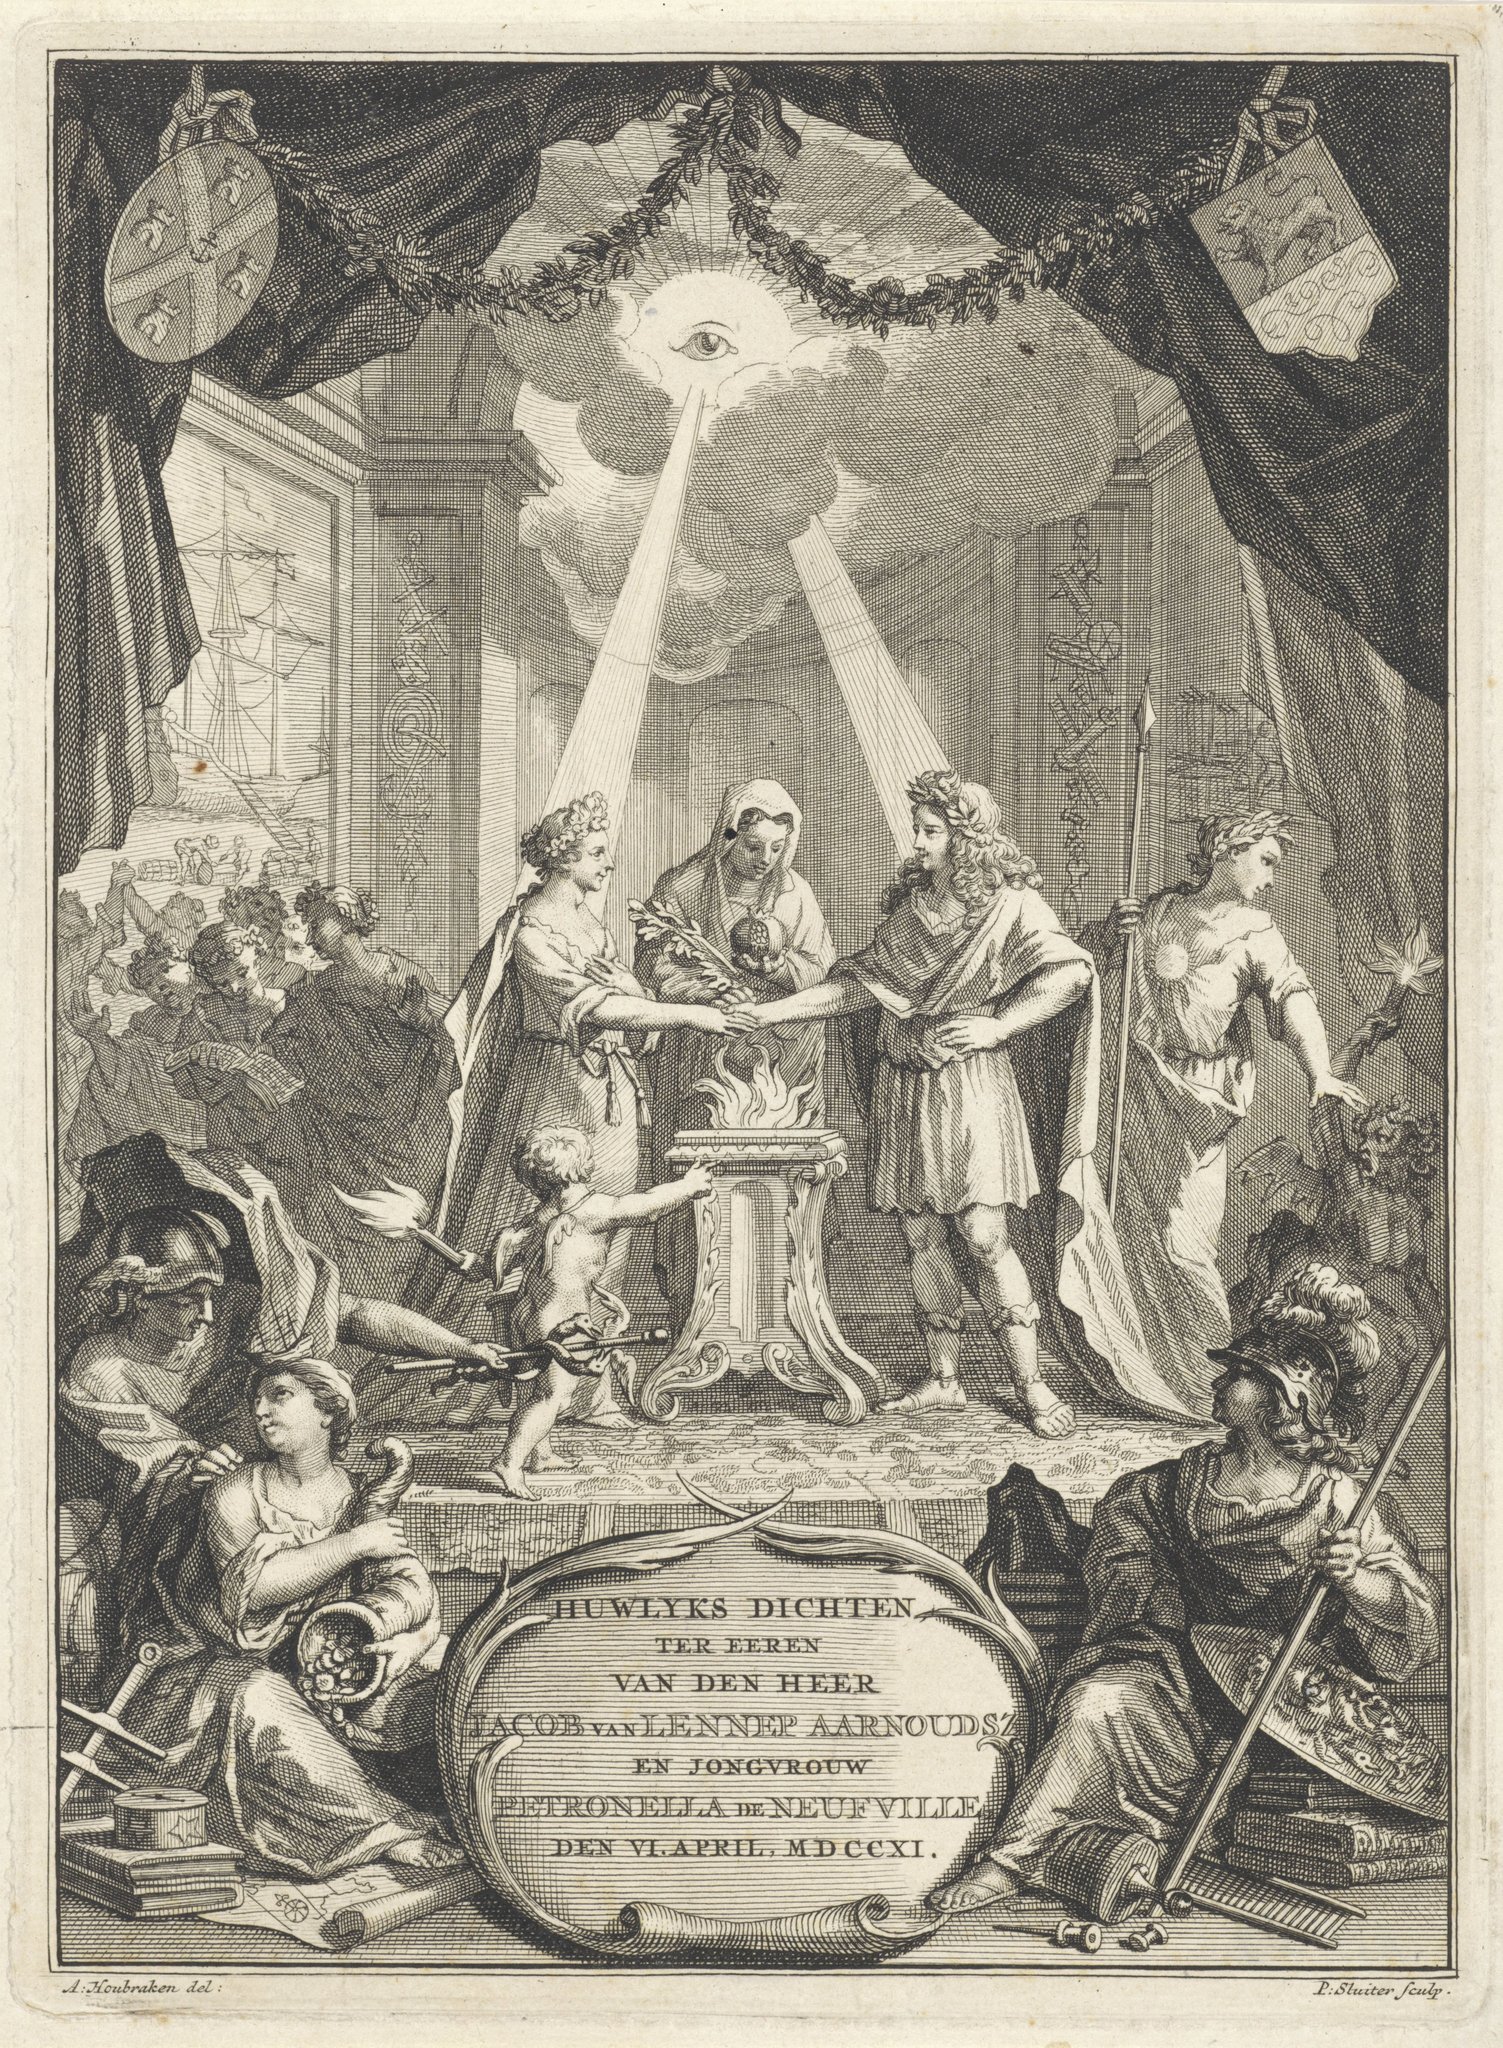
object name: titelblad, titelpagina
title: Titelpagina voor: Huwelyks dichten ter gelukkiger verëeniginge van (...) Jacob van Lennep Aarnoudsz. met jongvrouw Petronella de Neufville, 1711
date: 1711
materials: paper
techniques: engraving, etching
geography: amsterdam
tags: envy; 'invidia' (ripa) ~ personification of one of the seven deadly sins, (personifications and symbolic representations of) love; 'amore (secondo seneca)' (ripa), canals, waters (in city)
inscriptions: collector's mark: Lugt 2228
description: Aan weerszijden van een cartouche met de titel van het boek zitten Minerva en Voorspoed, die een hoorn des overvloeds met geldstukken vasthoudt. Mercurius tikt haar op de schouder. Onder het oog van God de Vader wordt daarboven het huwelijk voltrokken door een allegorische vrouwenfiguur met een granaatappel en olijftak in de hand. Bruid en bruidegom geven elkaar de hand boven een altaar met offervuur. Achter de bruidegom staat de Liefde die Afgunst weghoudt van het bruidspaar. Op de achtergrond zingende en dansende mensen en een doorkijk naar een voor anker liggende driemaster. Bovenaan de wapenschilden van beide families.